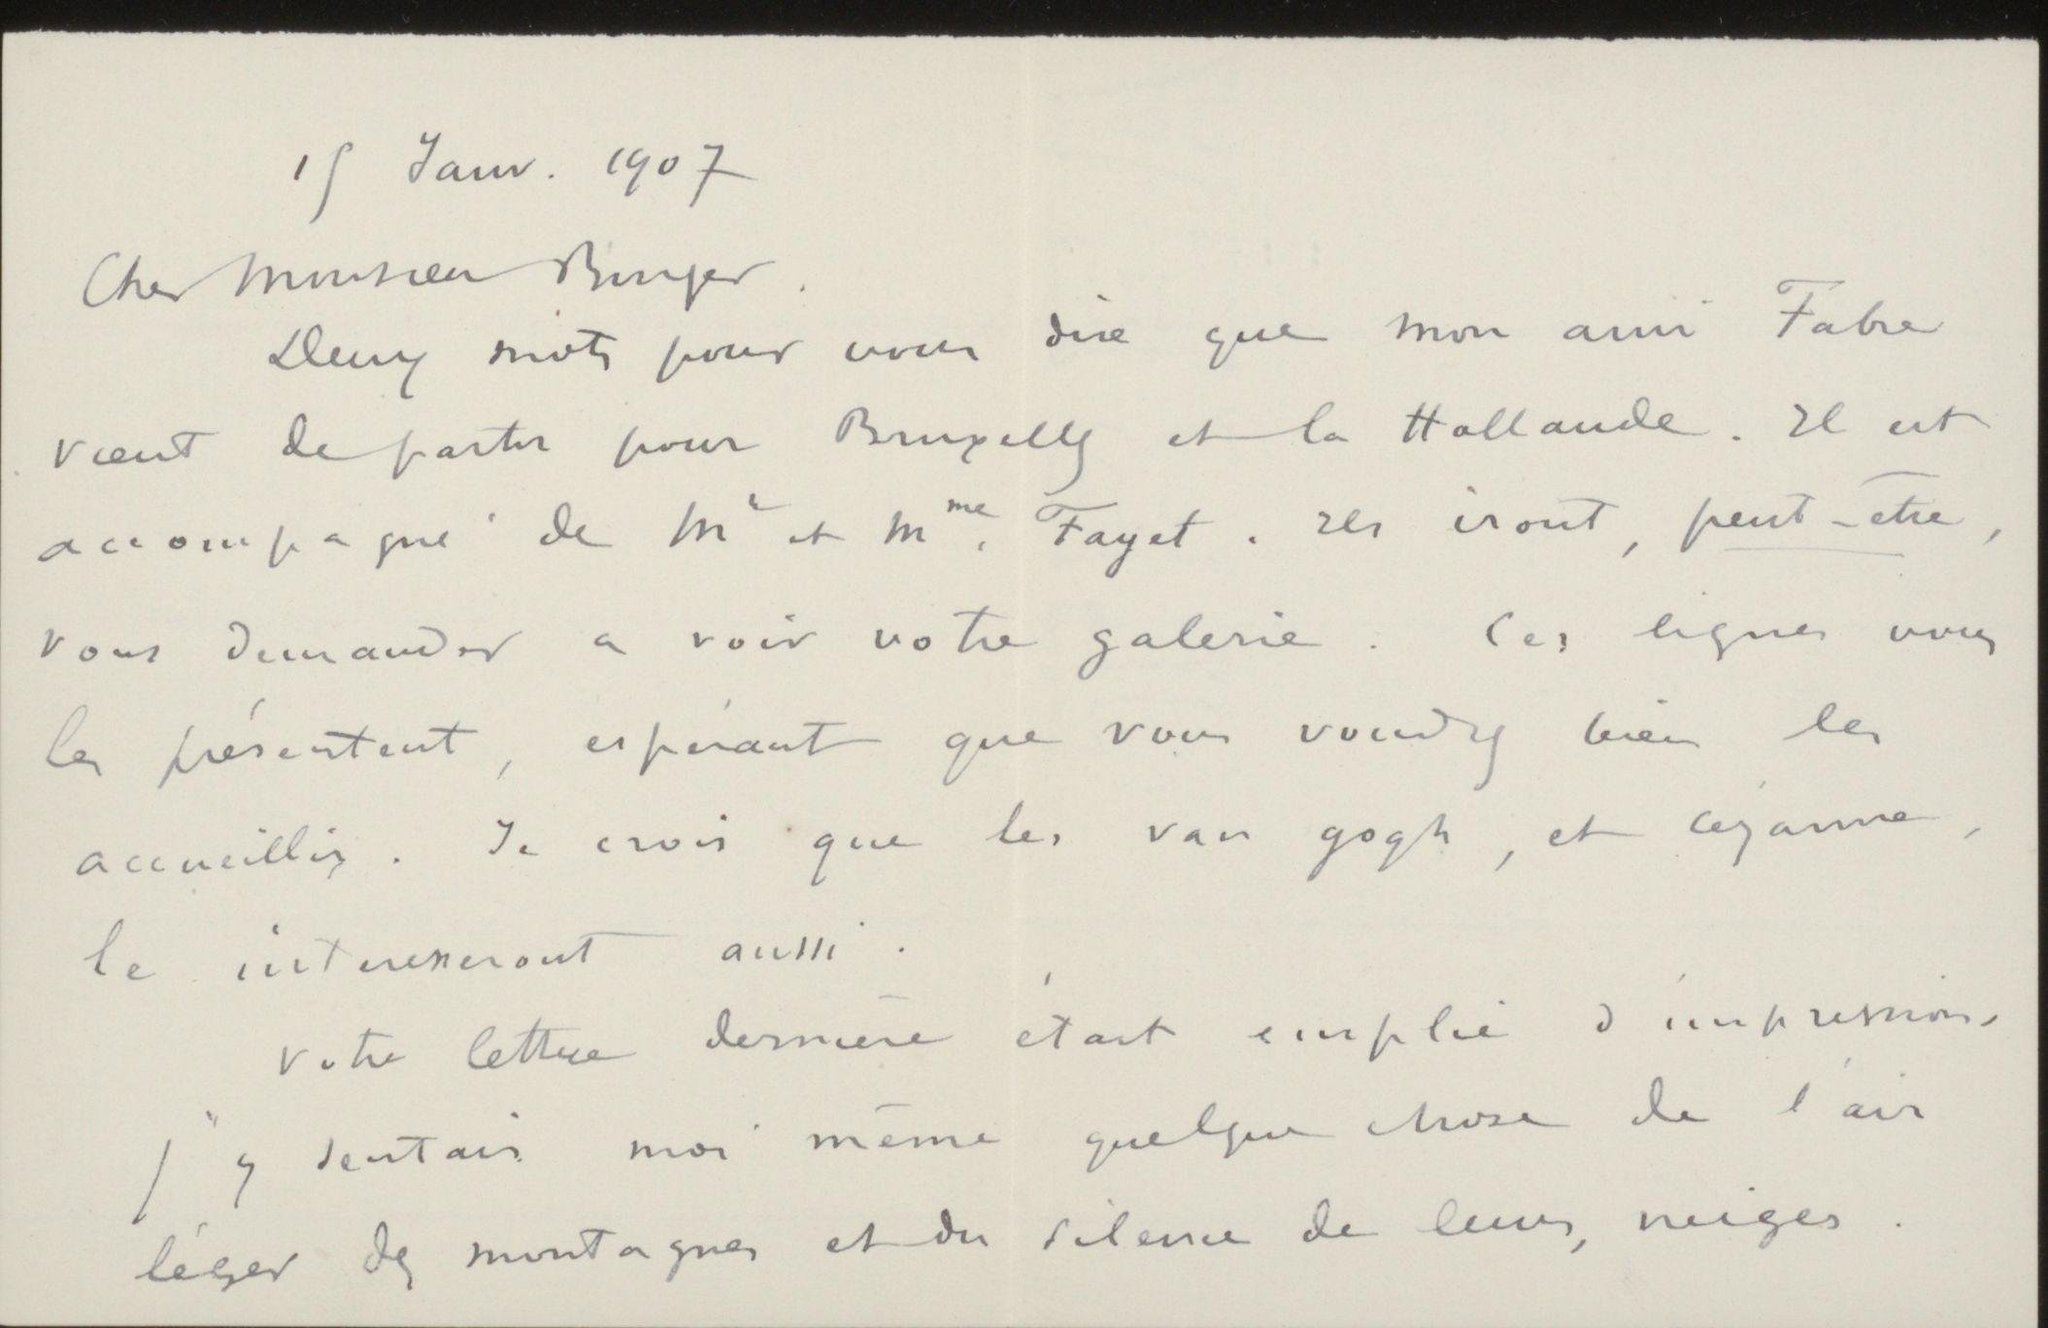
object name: letter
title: Brief aan Andries Bonger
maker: odilon redon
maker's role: draughtsman, painter, print maker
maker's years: 1840-1916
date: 1907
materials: ink, paper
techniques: pen, writing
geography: paris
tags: vincent van gogh, paul cézanne, amsterdam, andries bonger, designer, ceramicist, art collecting, netherlands, brussels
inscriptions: watermark